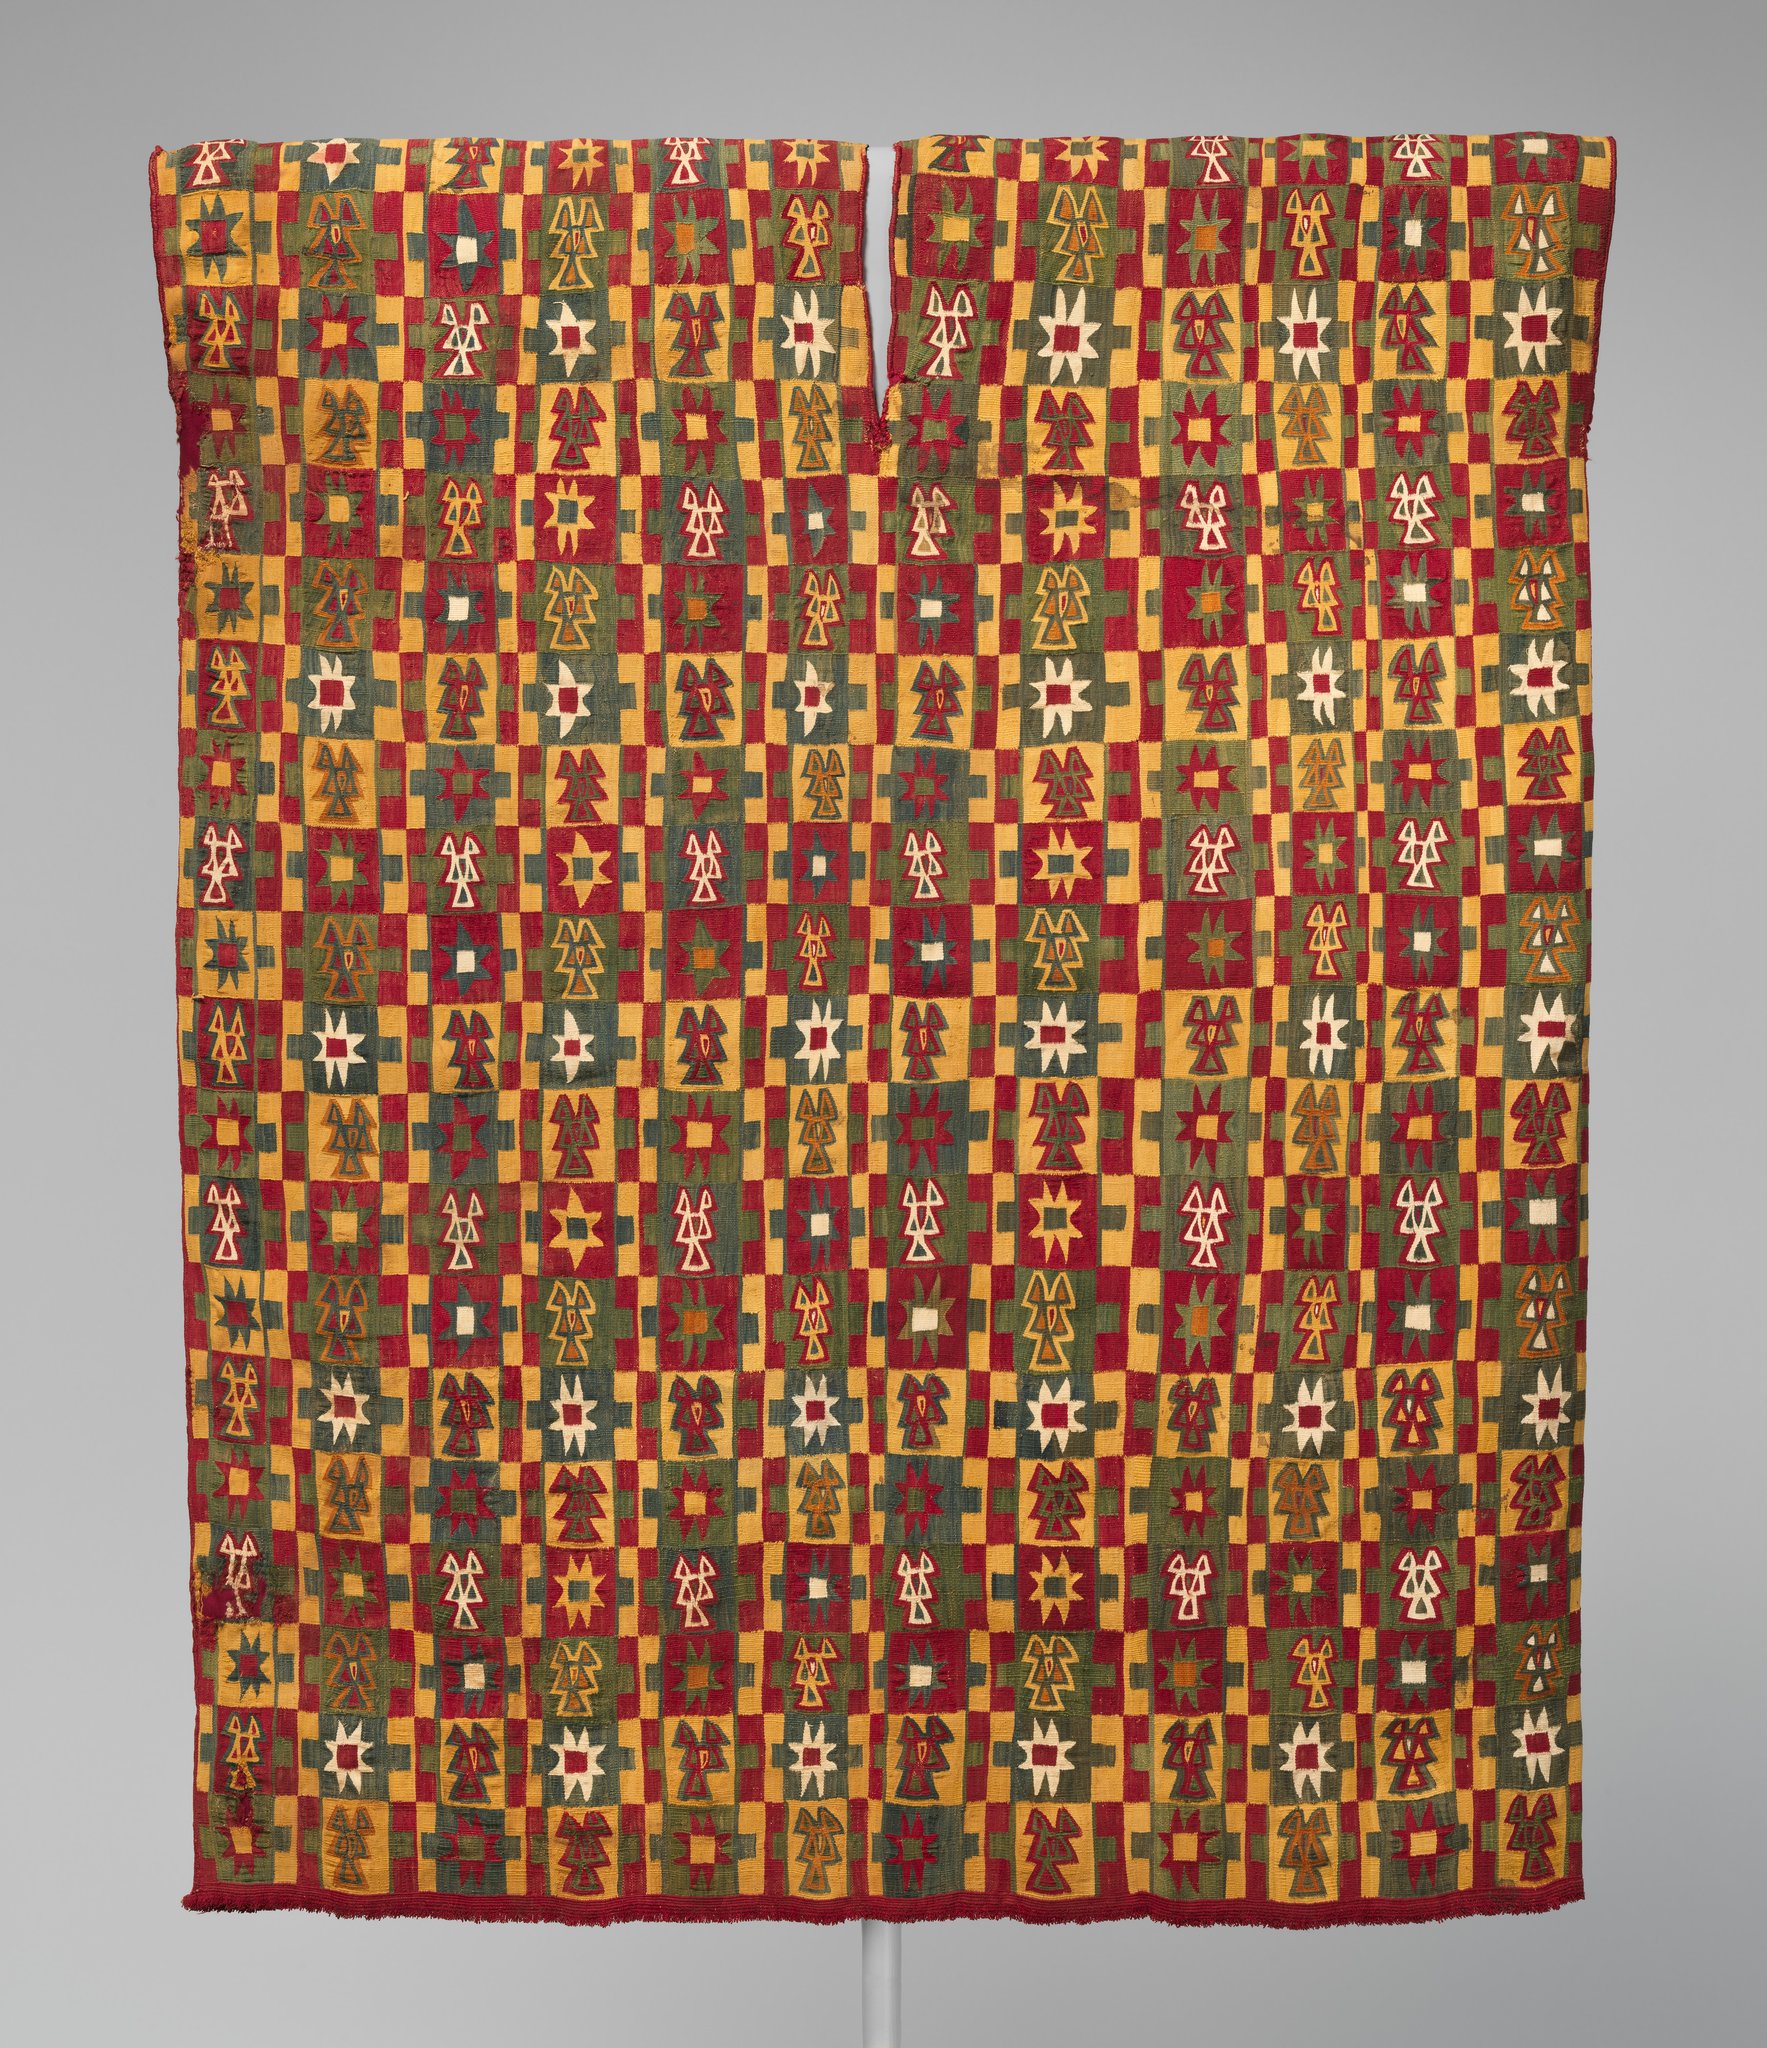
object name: tunic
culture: inca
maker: chuquibamba artist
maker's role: artist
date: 1460-1540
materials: animal fiber, cotton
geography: peru